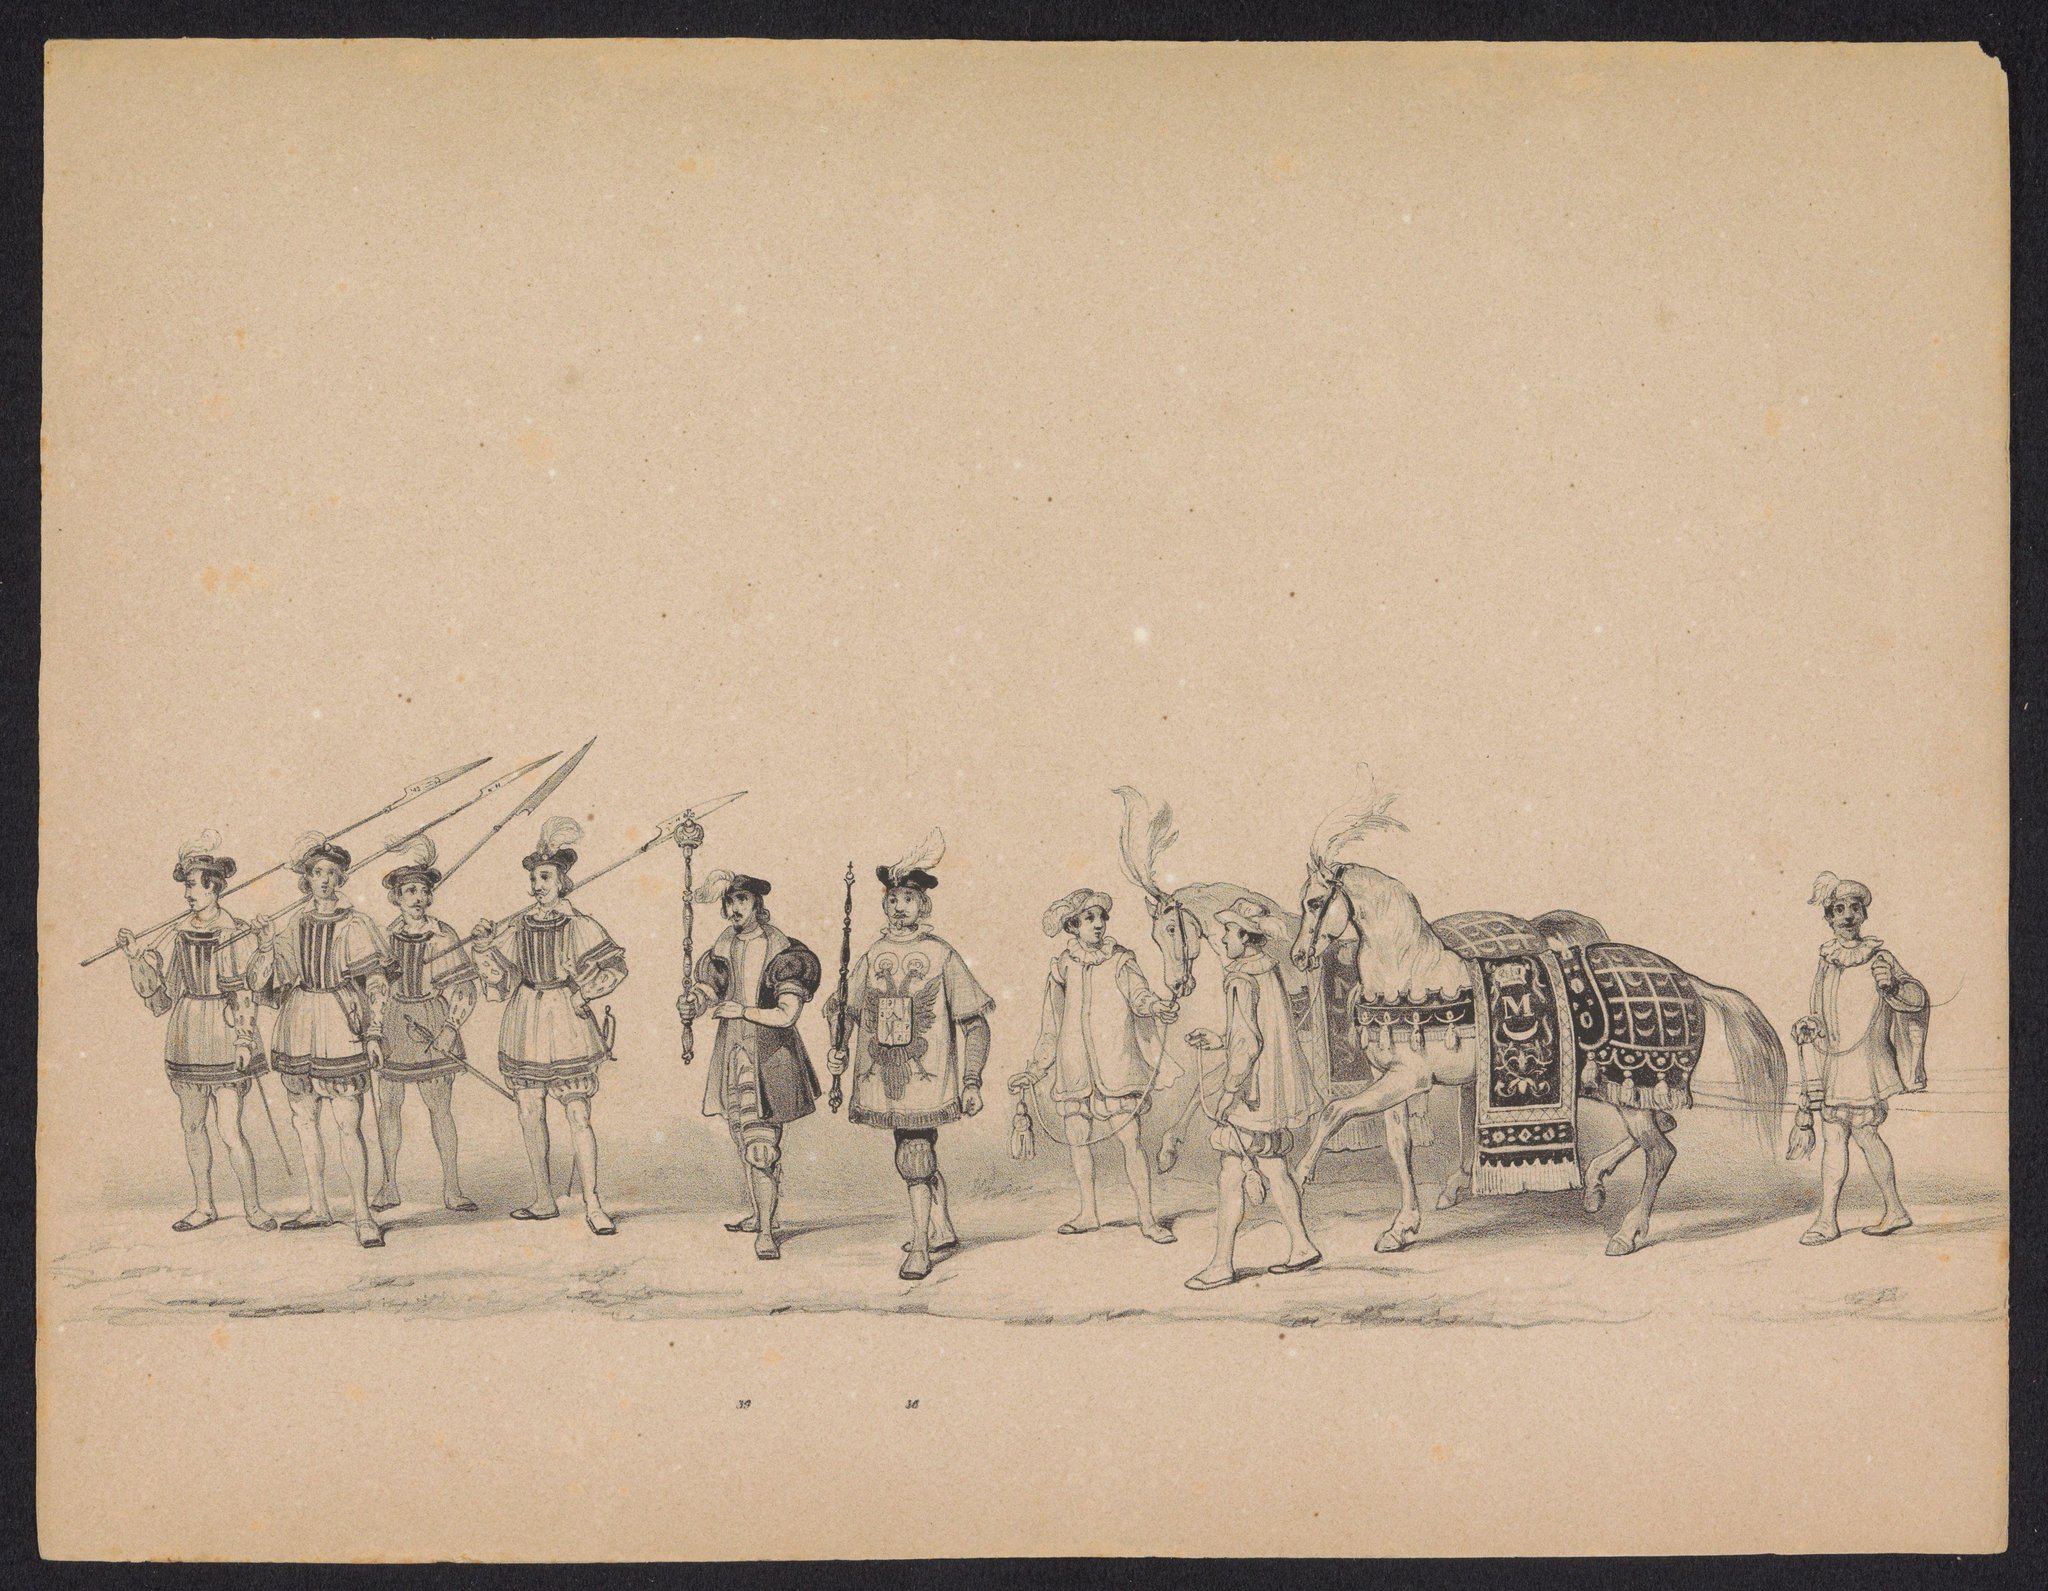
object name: print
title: Maskerade van de Utrechtse studenten, 1846 (plaat 7)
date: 1847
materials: paper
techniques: lithograph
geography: leiden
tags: philip ii of spain, students' pageant, costumes used in pageants, utrecht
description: Historische gekostumeerde optocht van de studenten van de Utrechtse Hogeschool gehouden op 17 juni 1846 ter gelegenheid van het 210-jarig bestaan van de Hogeschool. De optocht verbeeldt de intocht van Filips II in Utrecht op 3 oktober 1549. Plaat met de groepen genummerd 38-39. Onderdeel van de serie van 22 aanelkaar te plakken losse bladen.